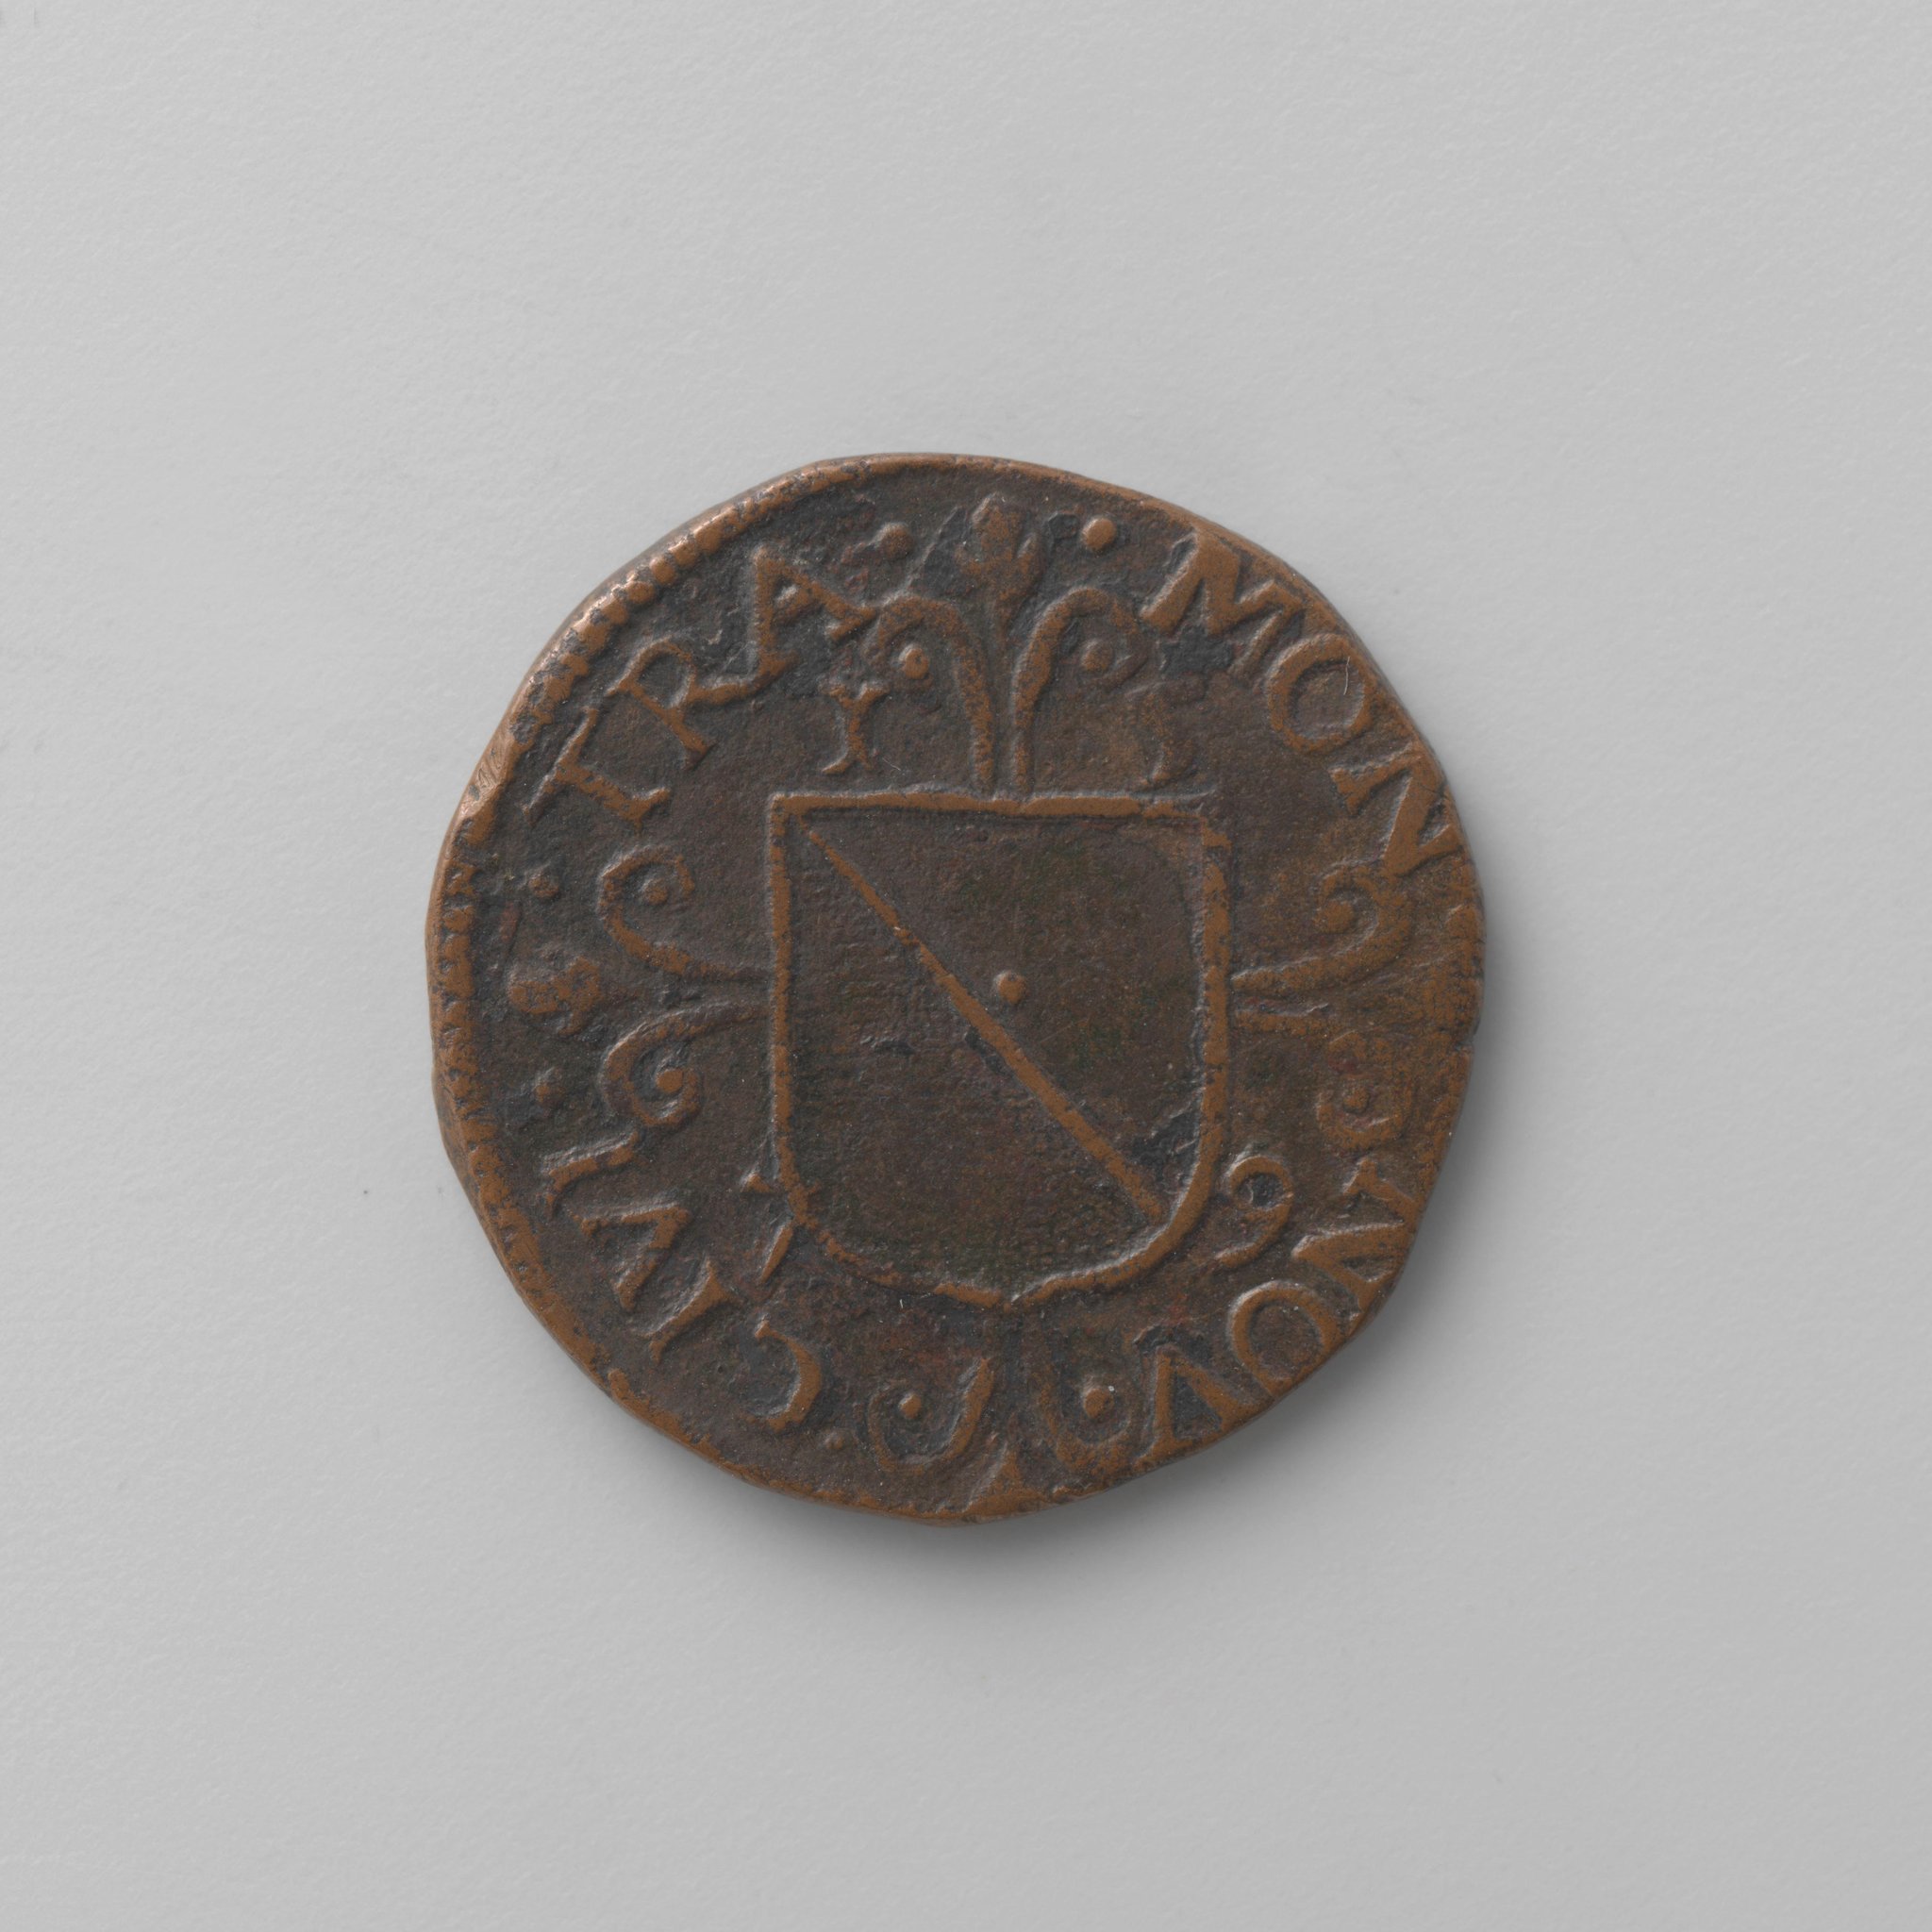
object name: oord, oortje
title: Stad Utrecht, oord op naam van Philips II, 1579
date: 1579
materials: copper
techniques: striking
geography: utrecht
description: Koperen munt. Voorzijde: gekroond wapenschild van Oostenrijk-Bourgondië. Keerzijde: op lang gebloemd kruis wapenschild van de stad Utrecht, met op de hoeken van het wapenschild de cijfers van het jaartal.